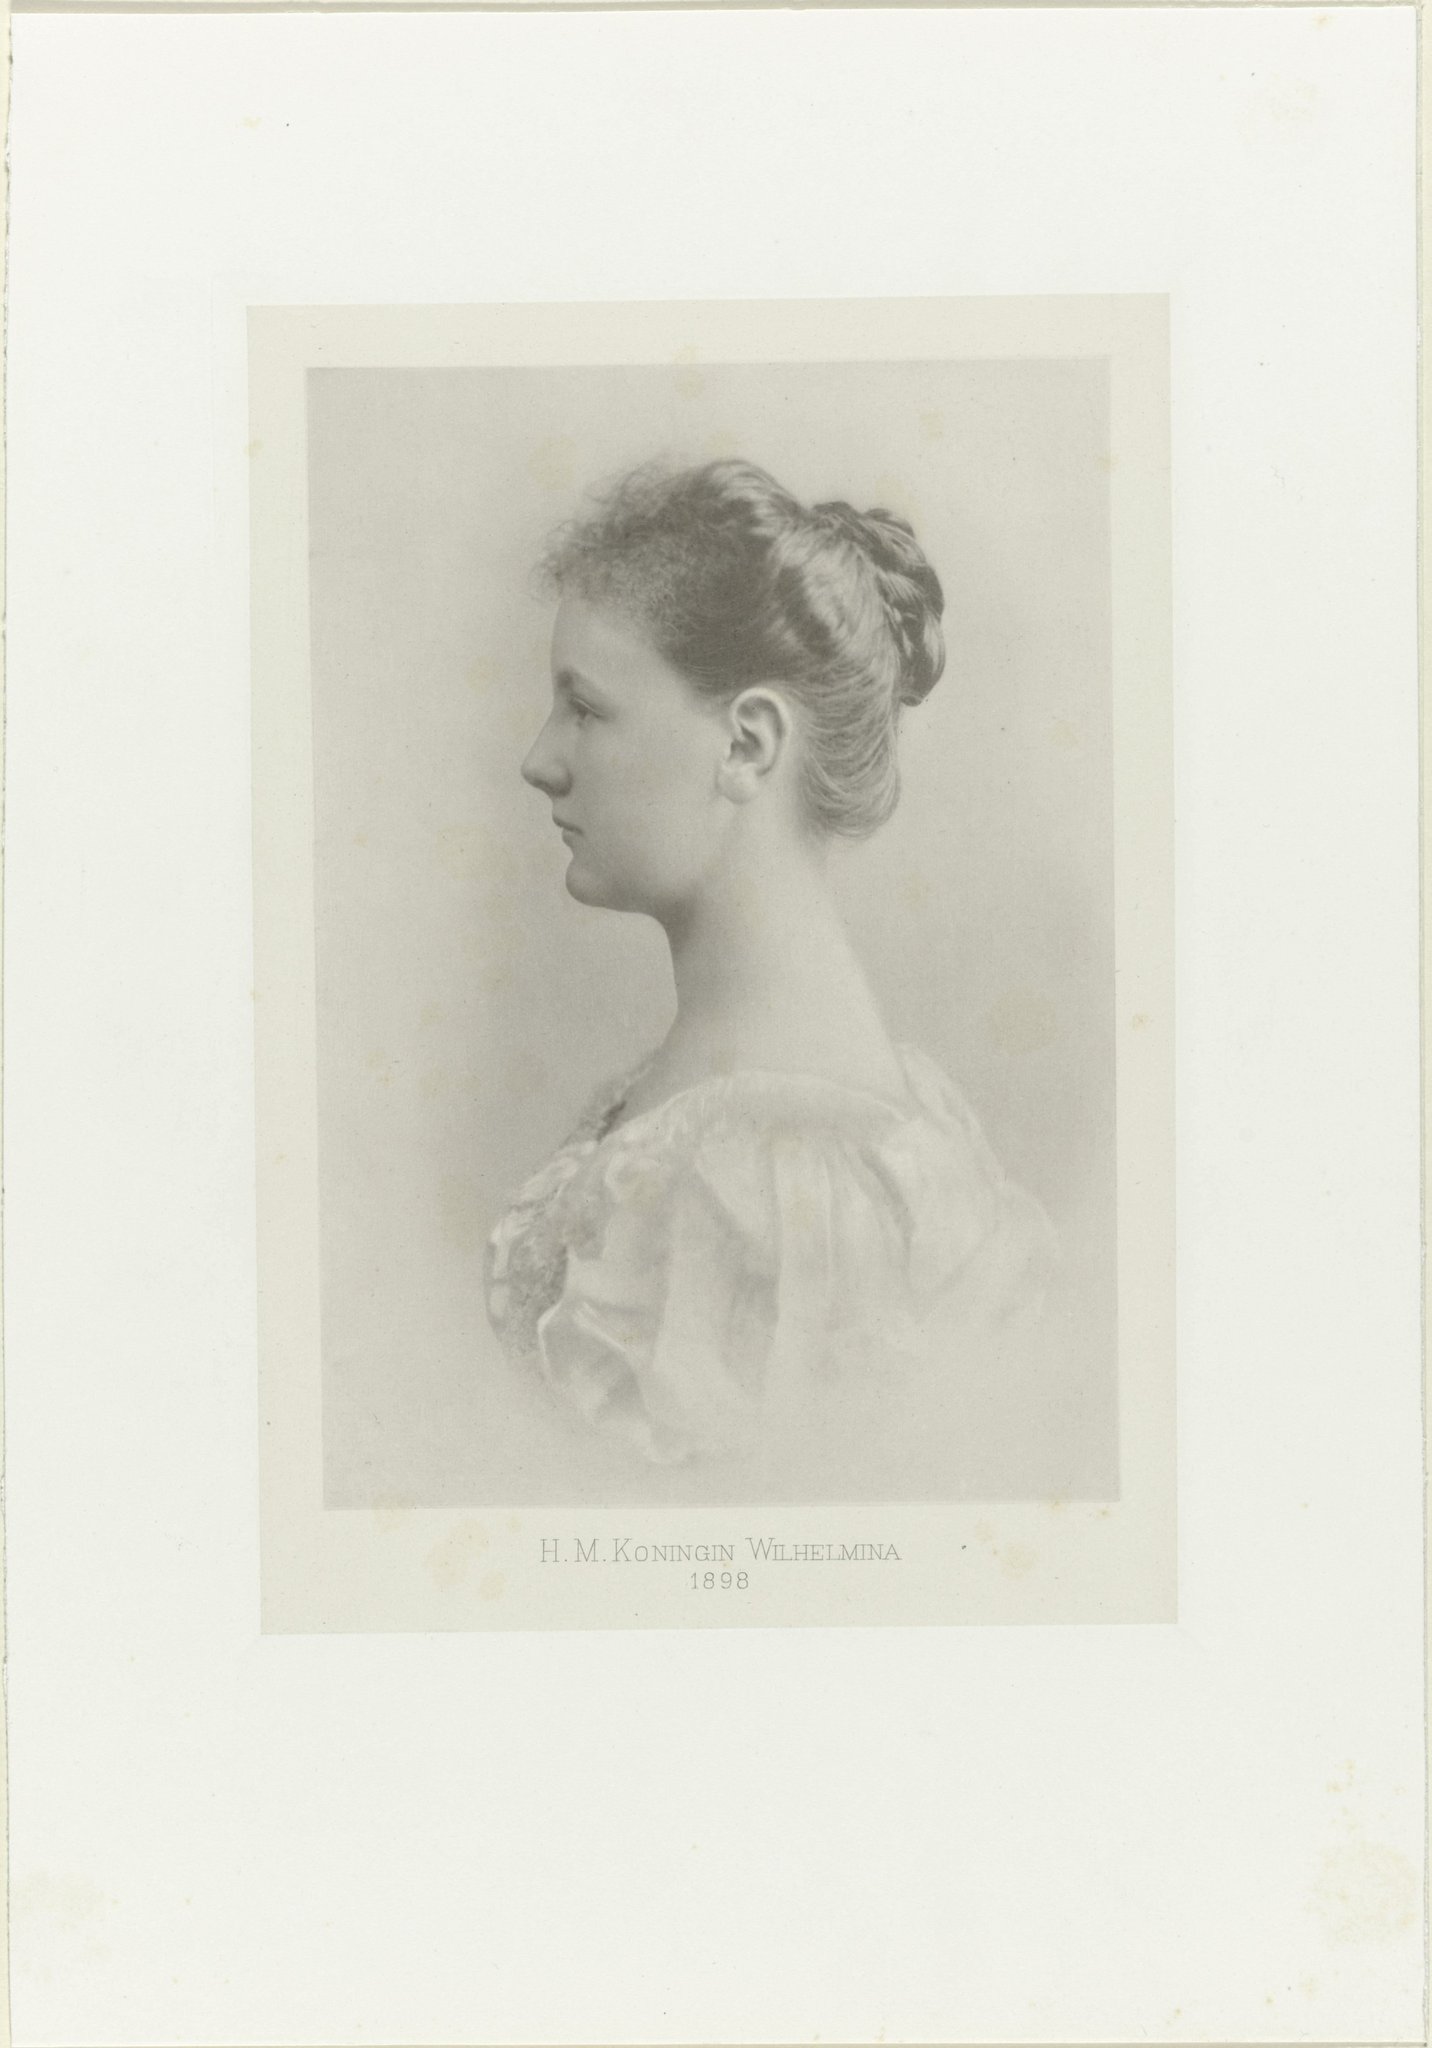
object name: photomechanical print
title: Portret van Wilhelmina, koningin der Nederlanden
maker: adolphe zimmermans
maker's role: fotograaf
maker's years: 1858-1922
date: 1898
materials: paper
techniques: photoaquatint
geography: berlin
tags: the hague, print maker, wilhelmina of the netherlands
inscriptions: date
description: De hier vermelde titel verwijst naar de hoogst verkregen titel van de geportretteerde, niet per se naar de titel die de geportretteerde op deze voorstelling draagt.